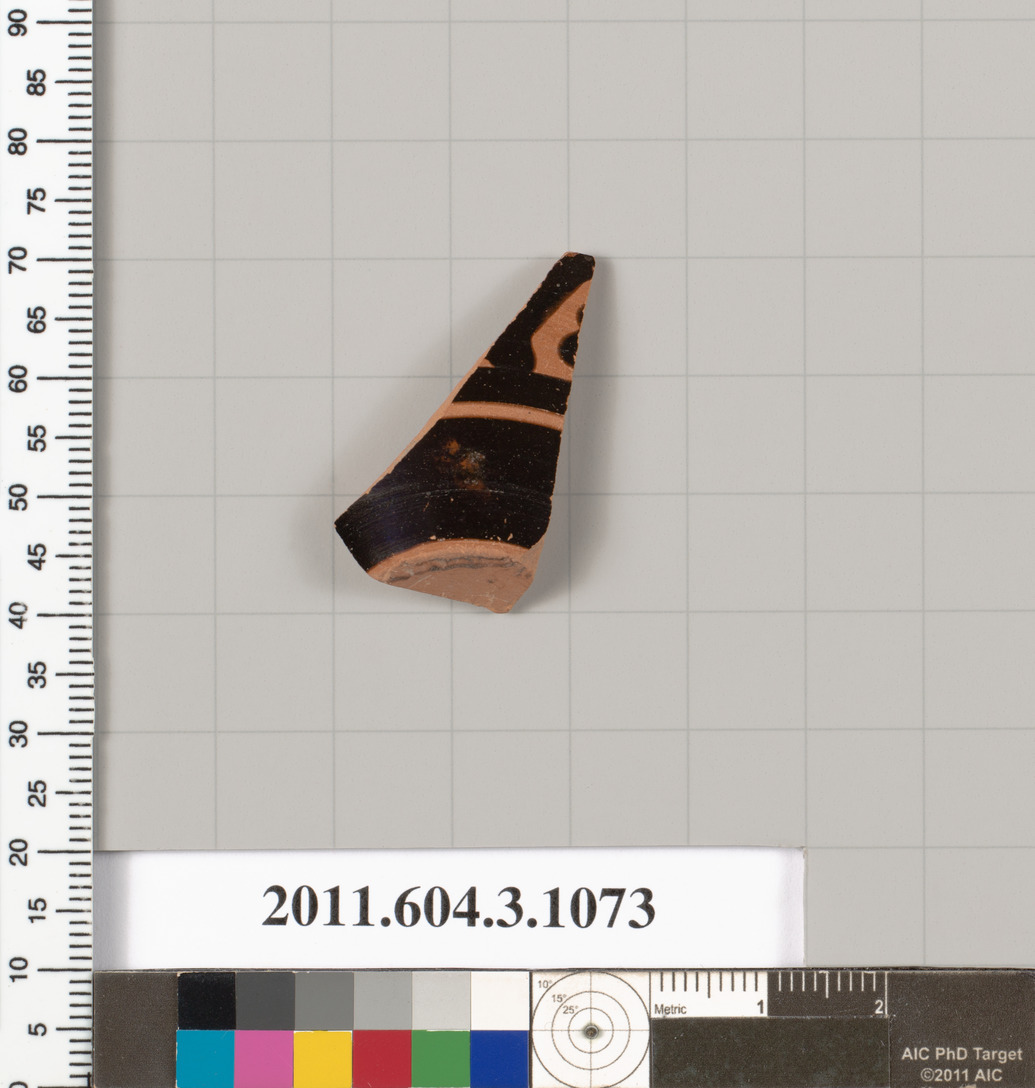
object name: mastoid fragment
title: Terracotta fragment of a mastoid (drinking cup with narrow base)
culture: greek, attic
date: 534-468 BCE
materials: terracotta